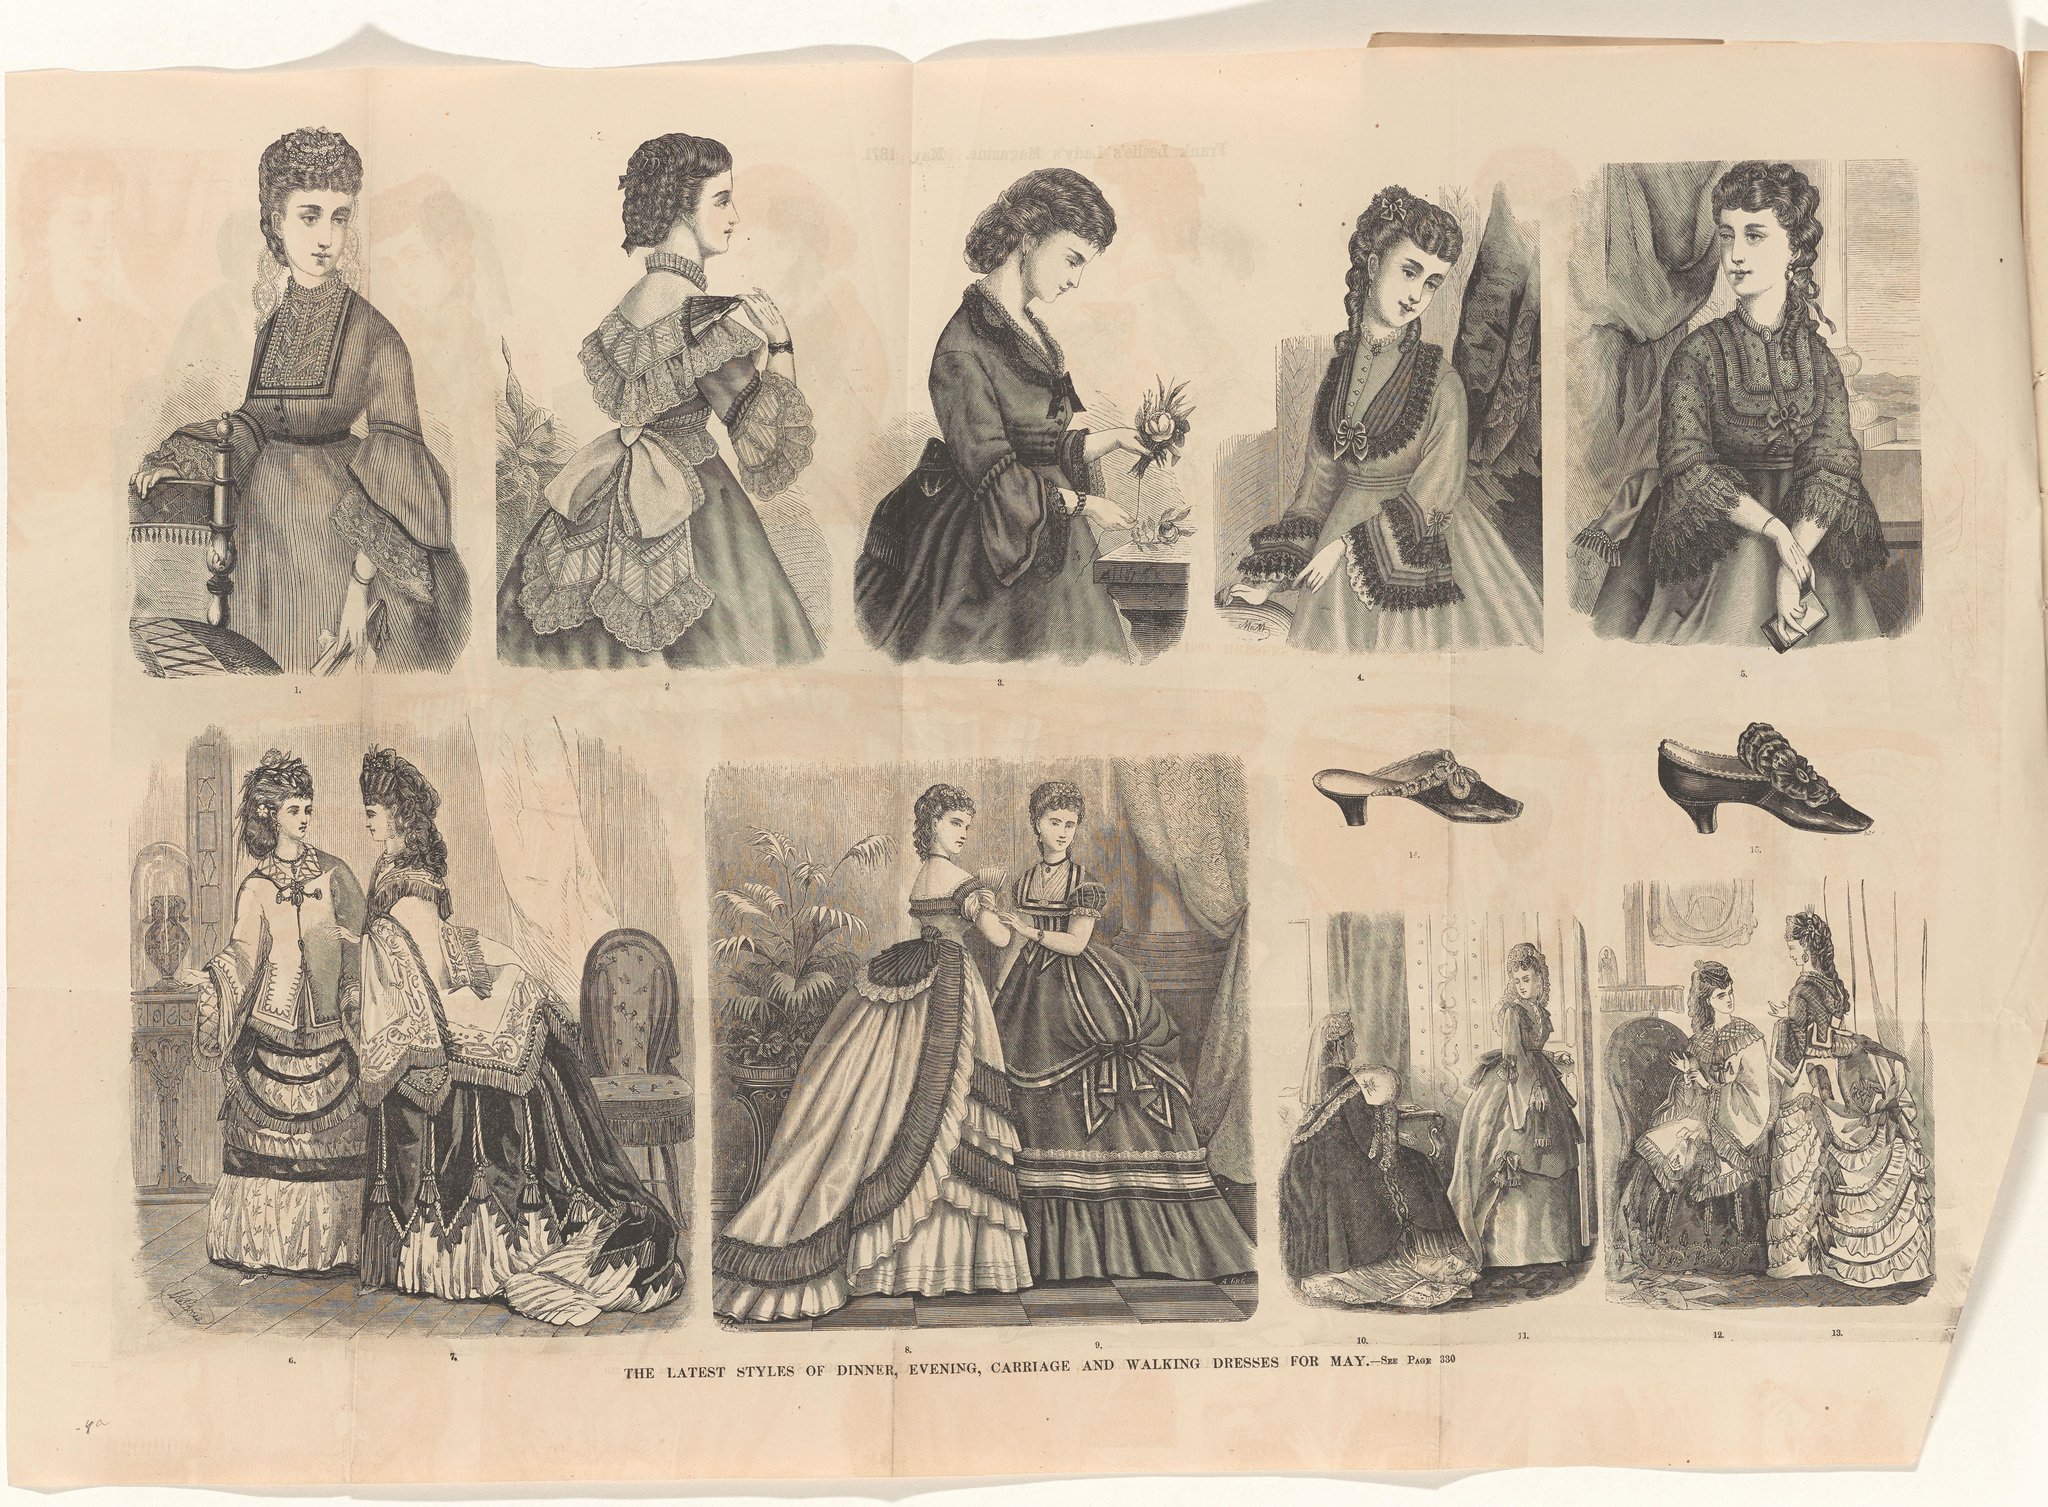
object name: fashion print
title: Lady's Magazine and Gazette of Fashion, Vol. XXVIII, may 1871: the latest styles for dinner, evening, carriage and walking dresses for may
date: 1871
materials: paper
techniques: engraving, hand coloring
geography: paris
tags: fashion plates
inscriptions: title: ‘Frank Leslie's Lady's Magazine MAY’, caption: ‘the latest styles for dinner, evening, carriage and walking dresses for may’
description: Uitvouwbare grote pagina met 13 japonnen voor het diner, de avond, het bezoek, de rijtoer en de wandeling, in twee rijen onder elkaar. Nr. 14 is een muiltje, nr. 15 een damesschoen met hak. Onderaan wordt verwezen naar pag. 330 voor nadere uitleg.